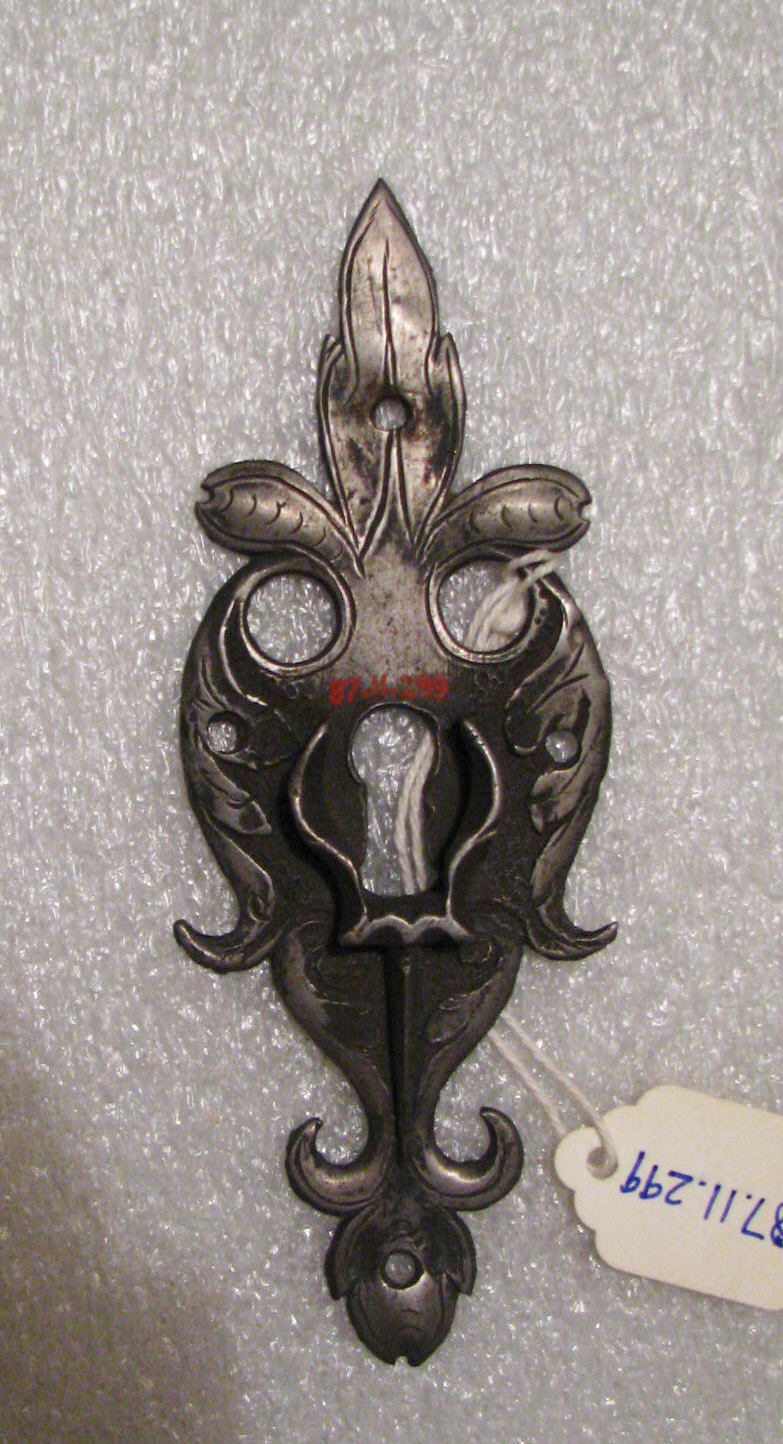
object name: escutcheon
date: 1501-1600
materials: iron